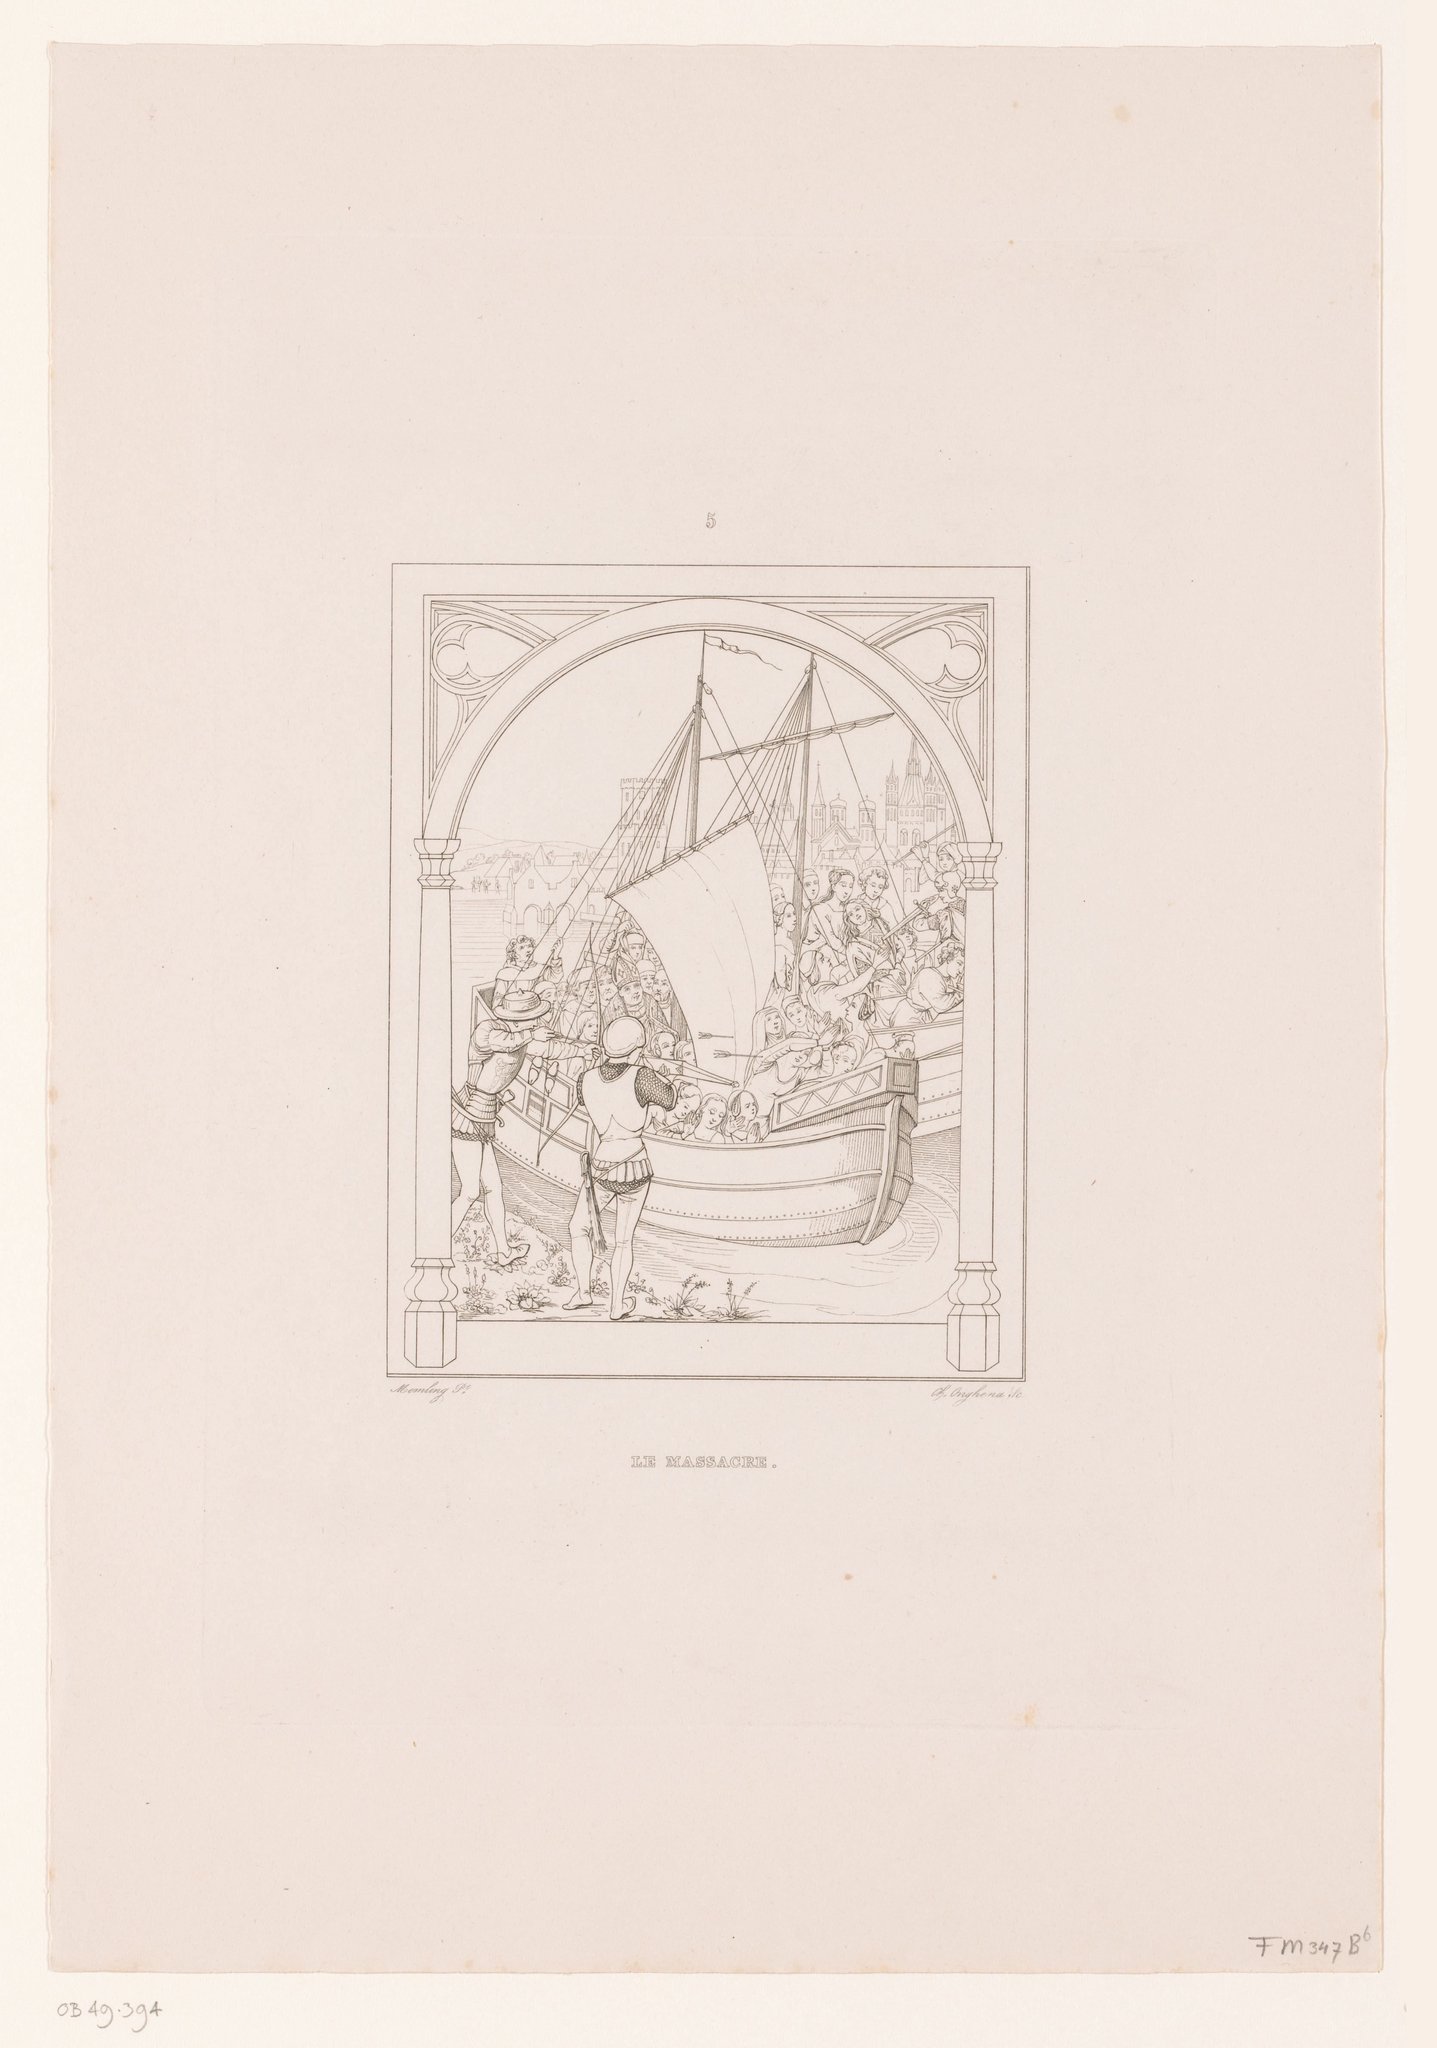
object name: print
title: Châsse van de H. Ursula in het Hospitaal van St. Jan te Brugge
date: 1841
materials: paper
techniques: etching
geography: brussels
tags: the virgin martyr ursula of cologne; possible attributes: arrow, banner with red cross, cloak of ermine, crown, ship, relics (and reliquaries)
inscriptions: collector's mark: Lugt 2228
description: Prent uit: Delepierre, Octave en Auguste Voisin. La Châsse de St. Ursule. Brussel: Société des Beaux-Arts, [1841].